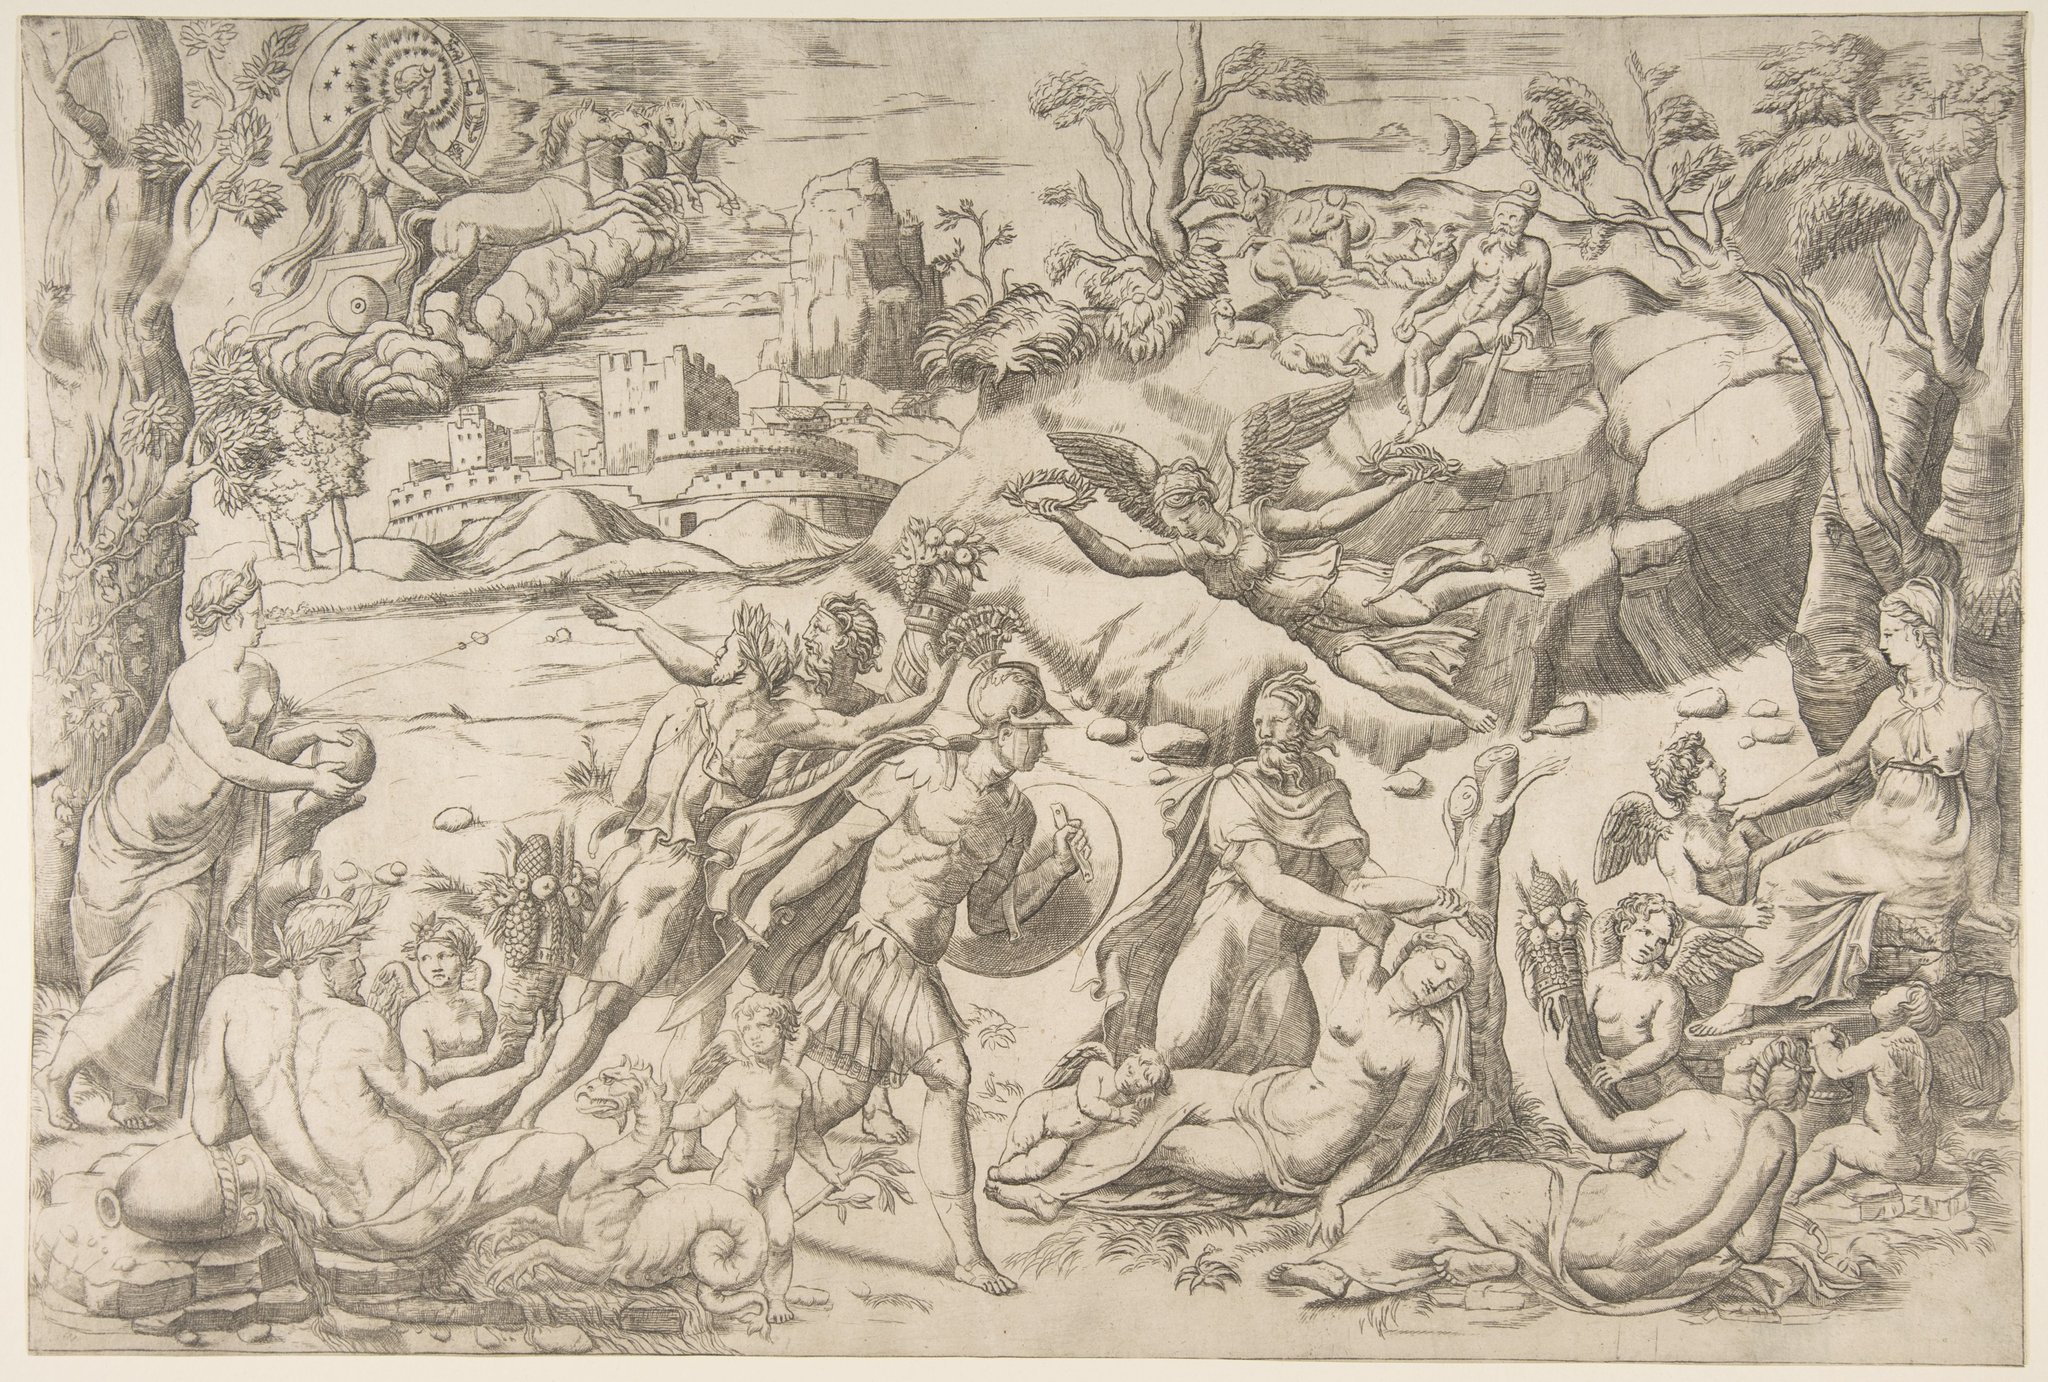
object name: print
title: Mars and Rhea Silvia: in the centre Mars holds a shield and sword, Rhea Silvia sleeping, Apollo in his chariot upper left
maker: giulio bonasone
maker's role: artist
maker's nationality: italian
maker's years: 1510-1576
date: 1531-1576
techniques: engraving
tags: men,women,apollo,dragons,putti,mars,horses,chariots